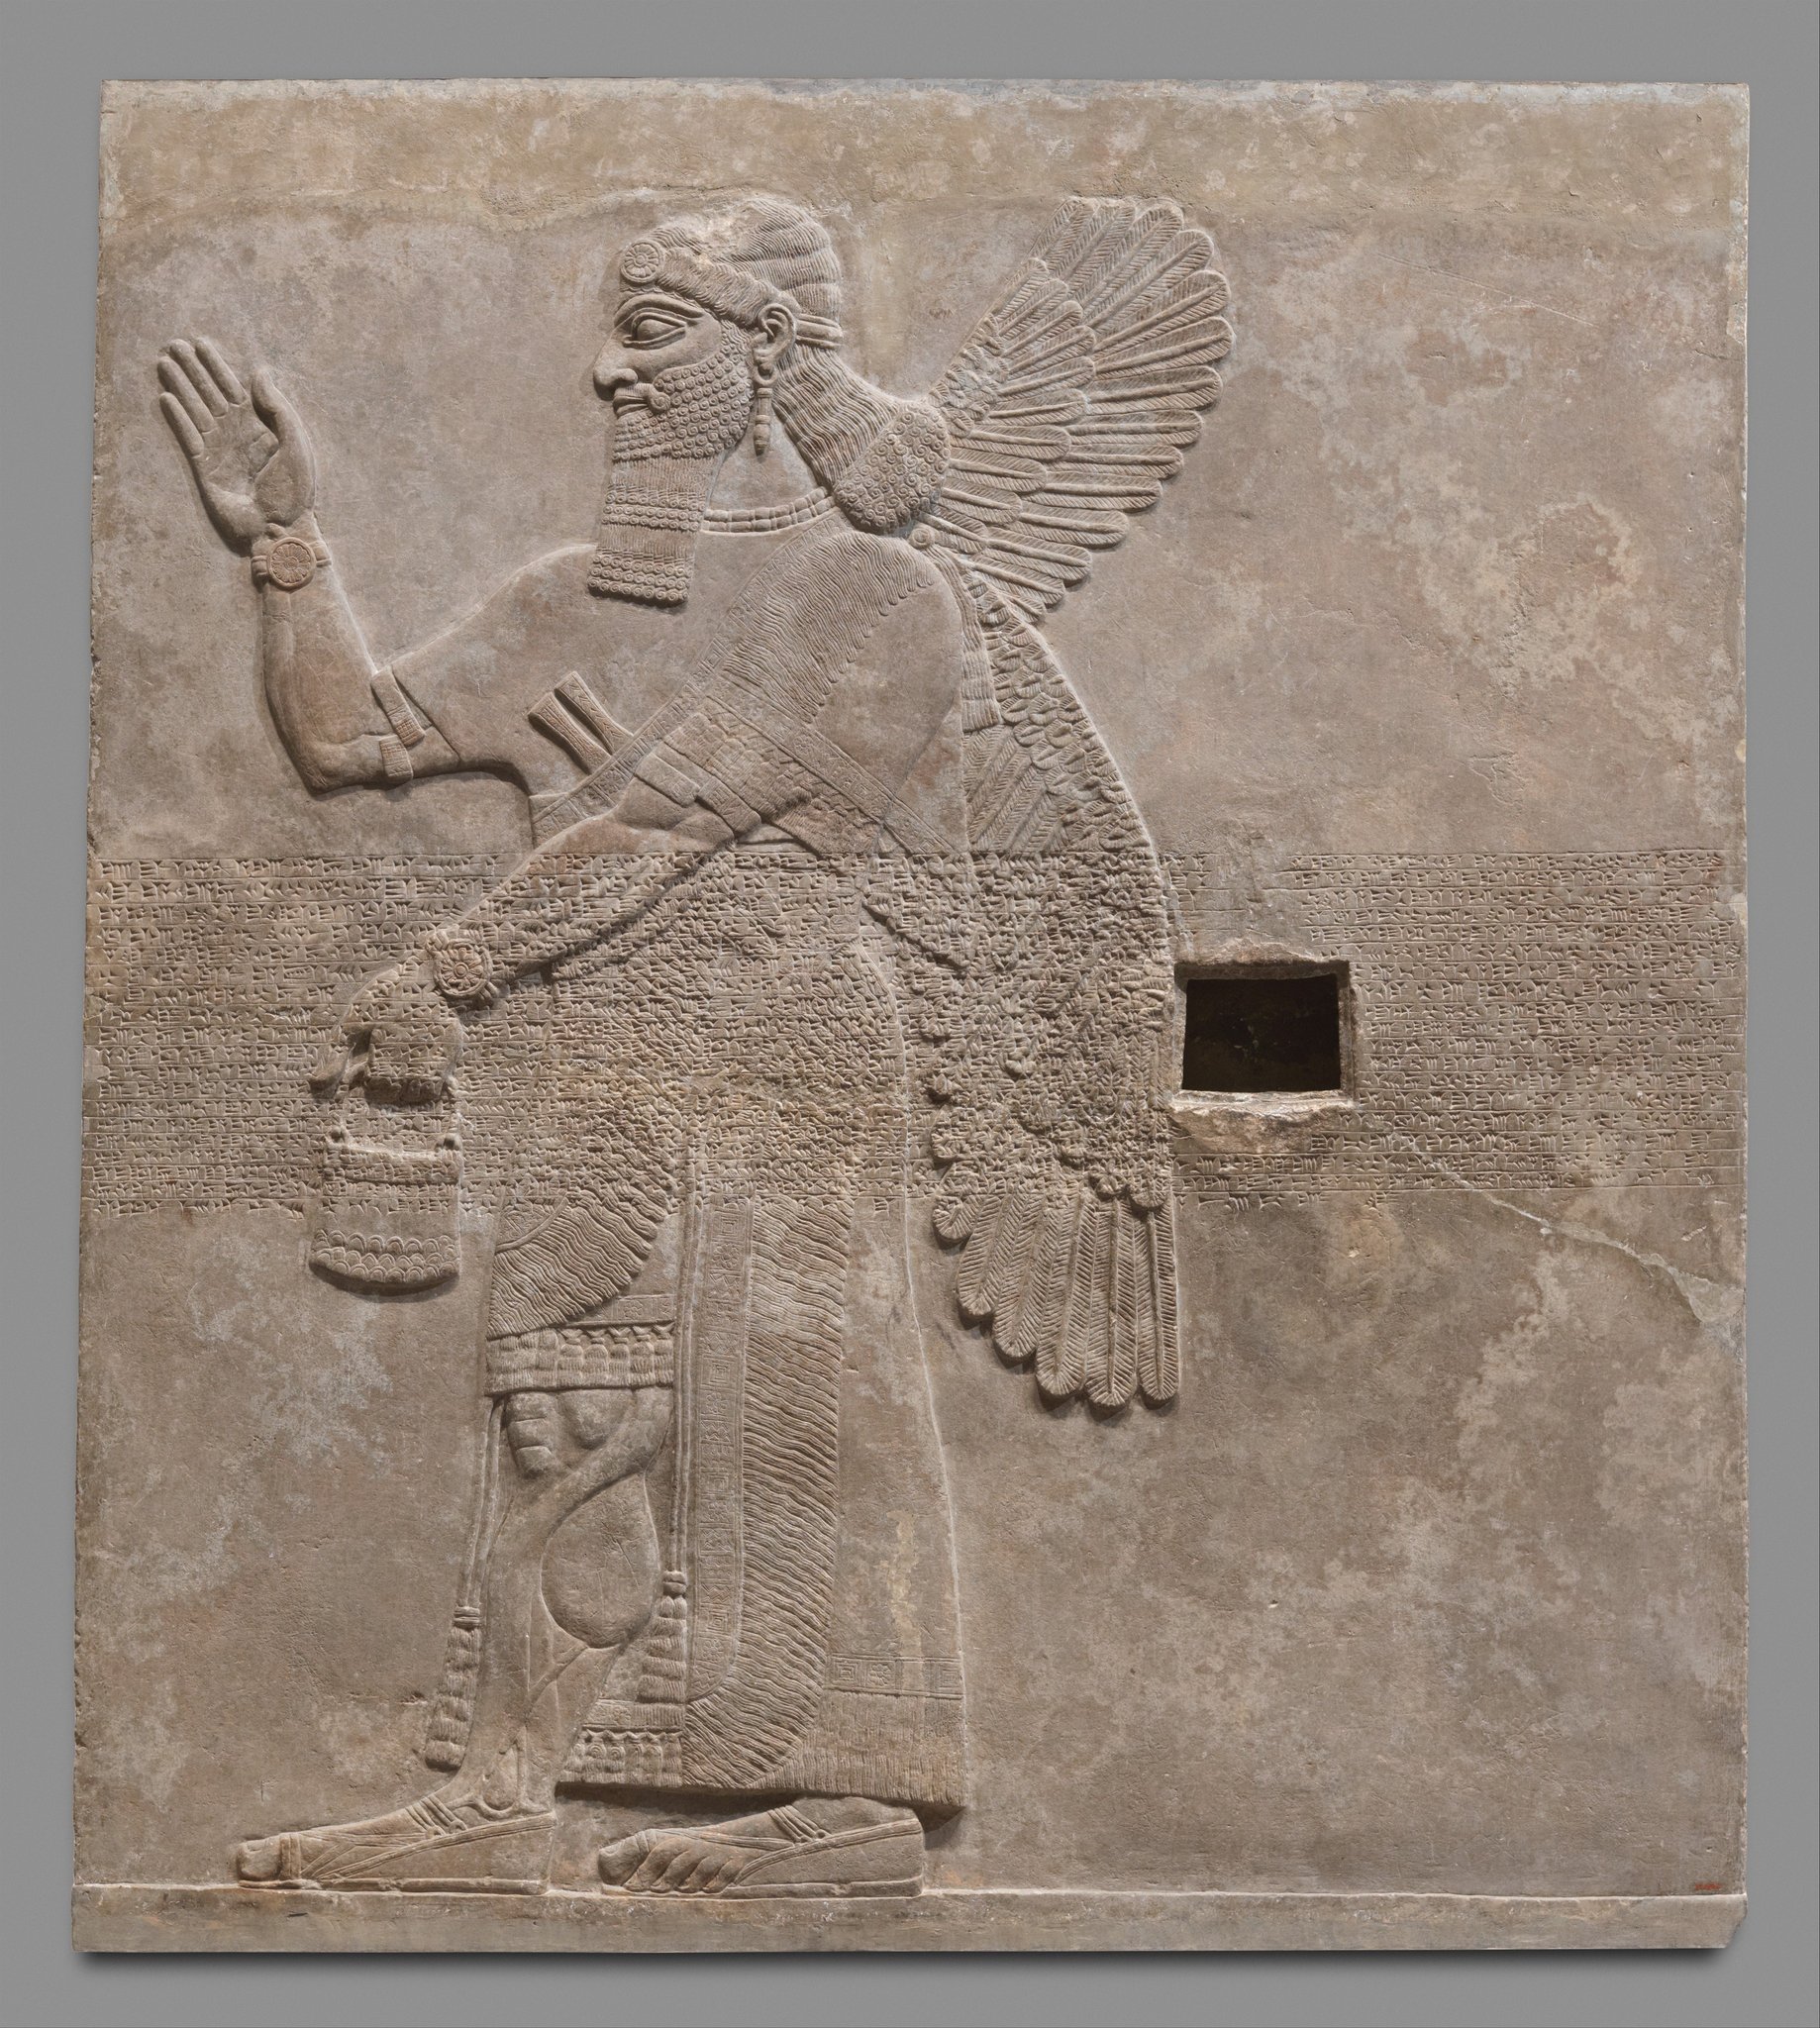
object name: relief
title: Relief panel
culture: assyrian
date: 883-859 BCE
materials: alabaster, gypsum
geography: mesopotamia